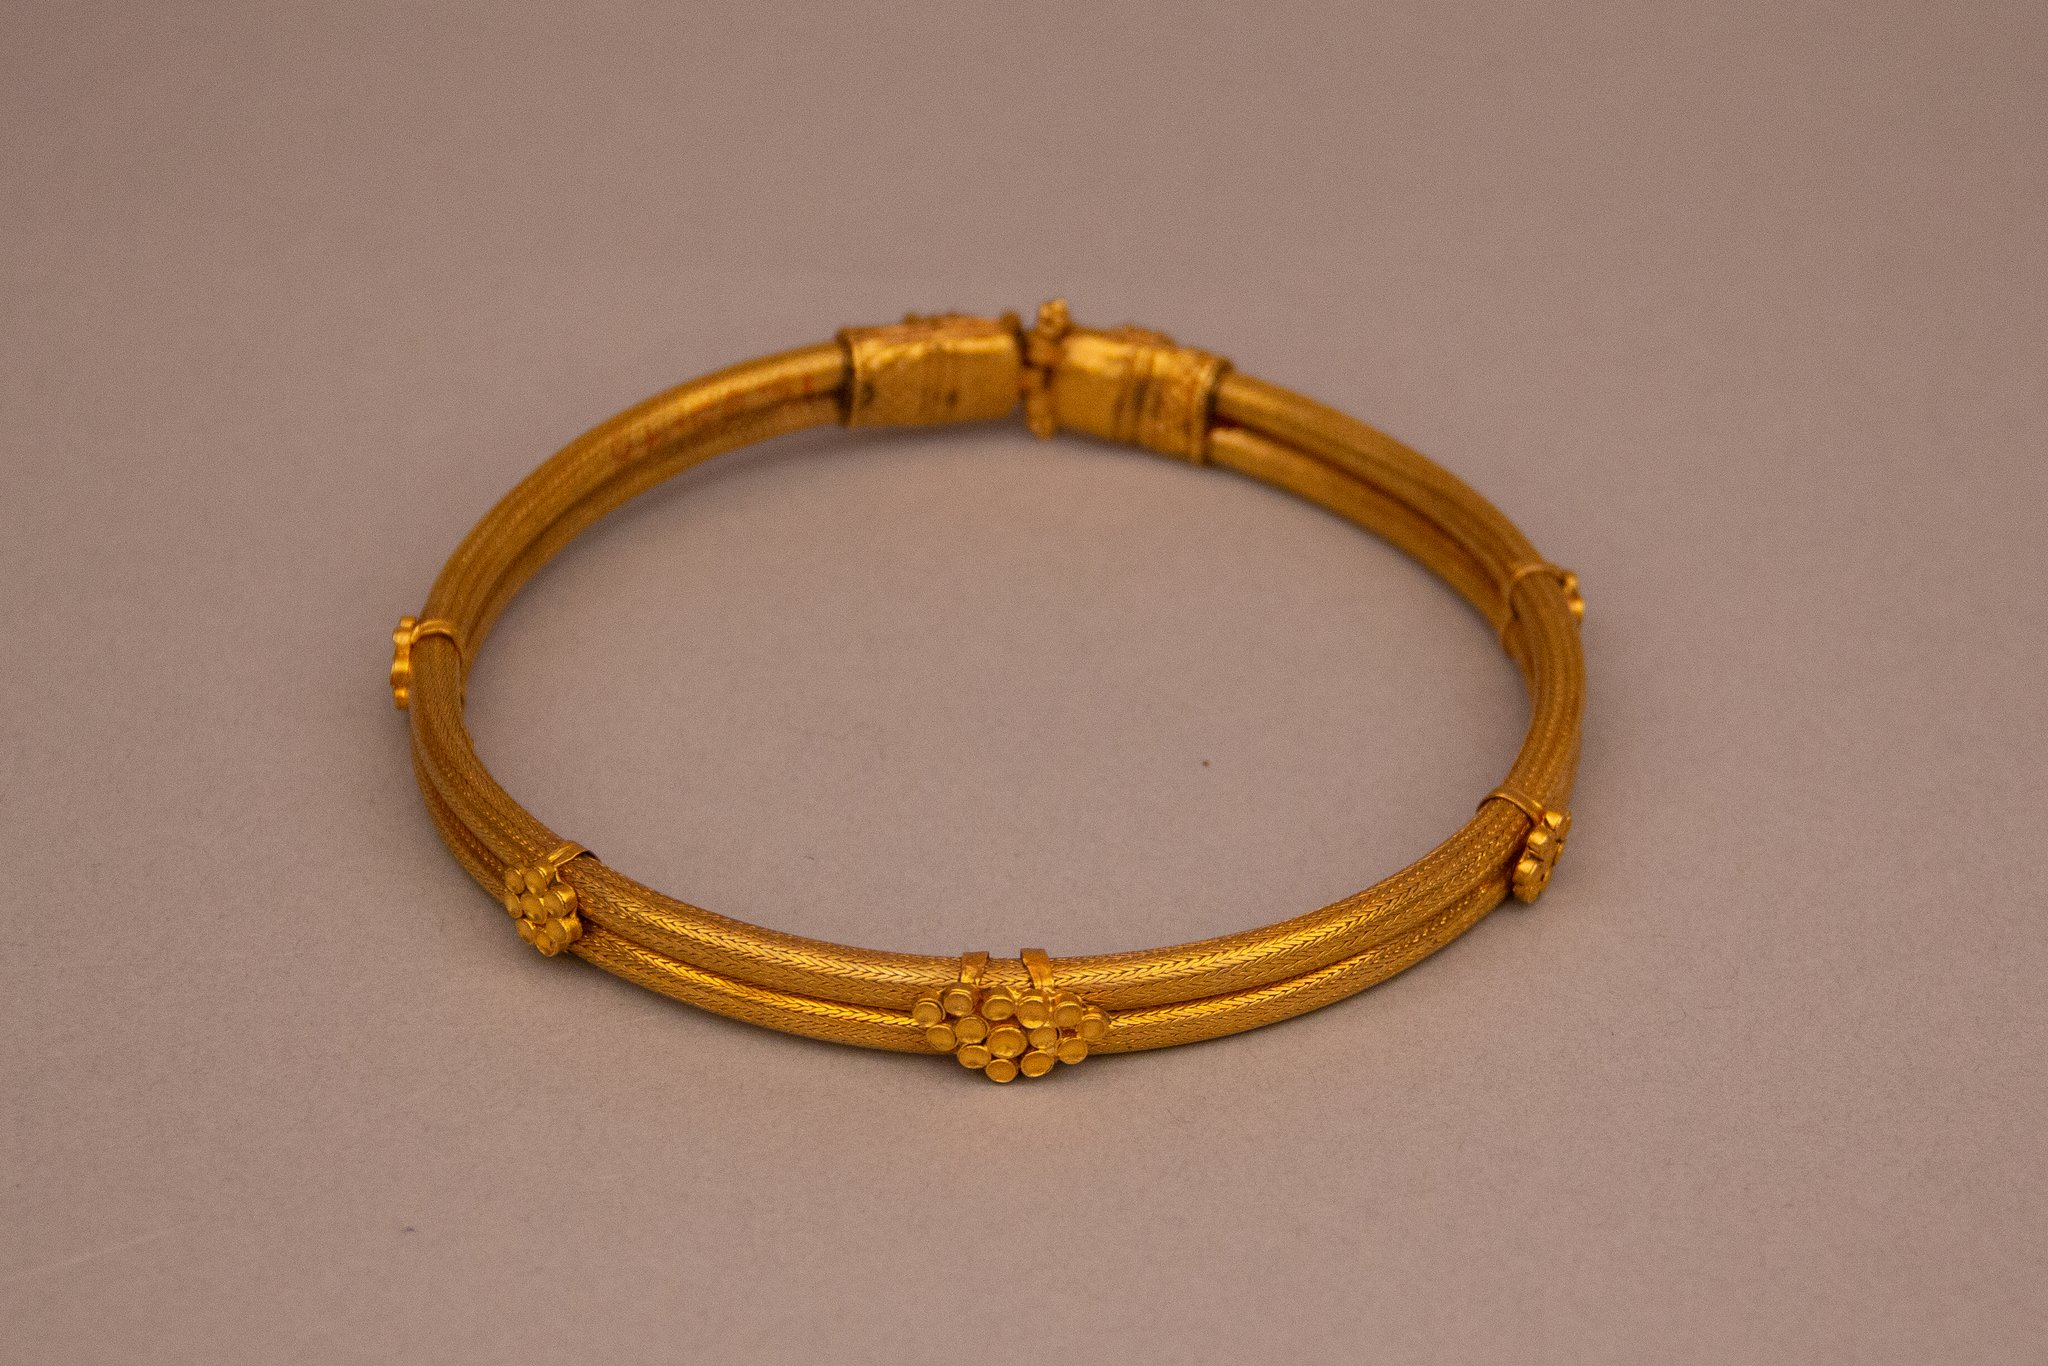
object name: necklet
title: Necklet (Musi)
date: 1601-1900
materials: gold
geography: india